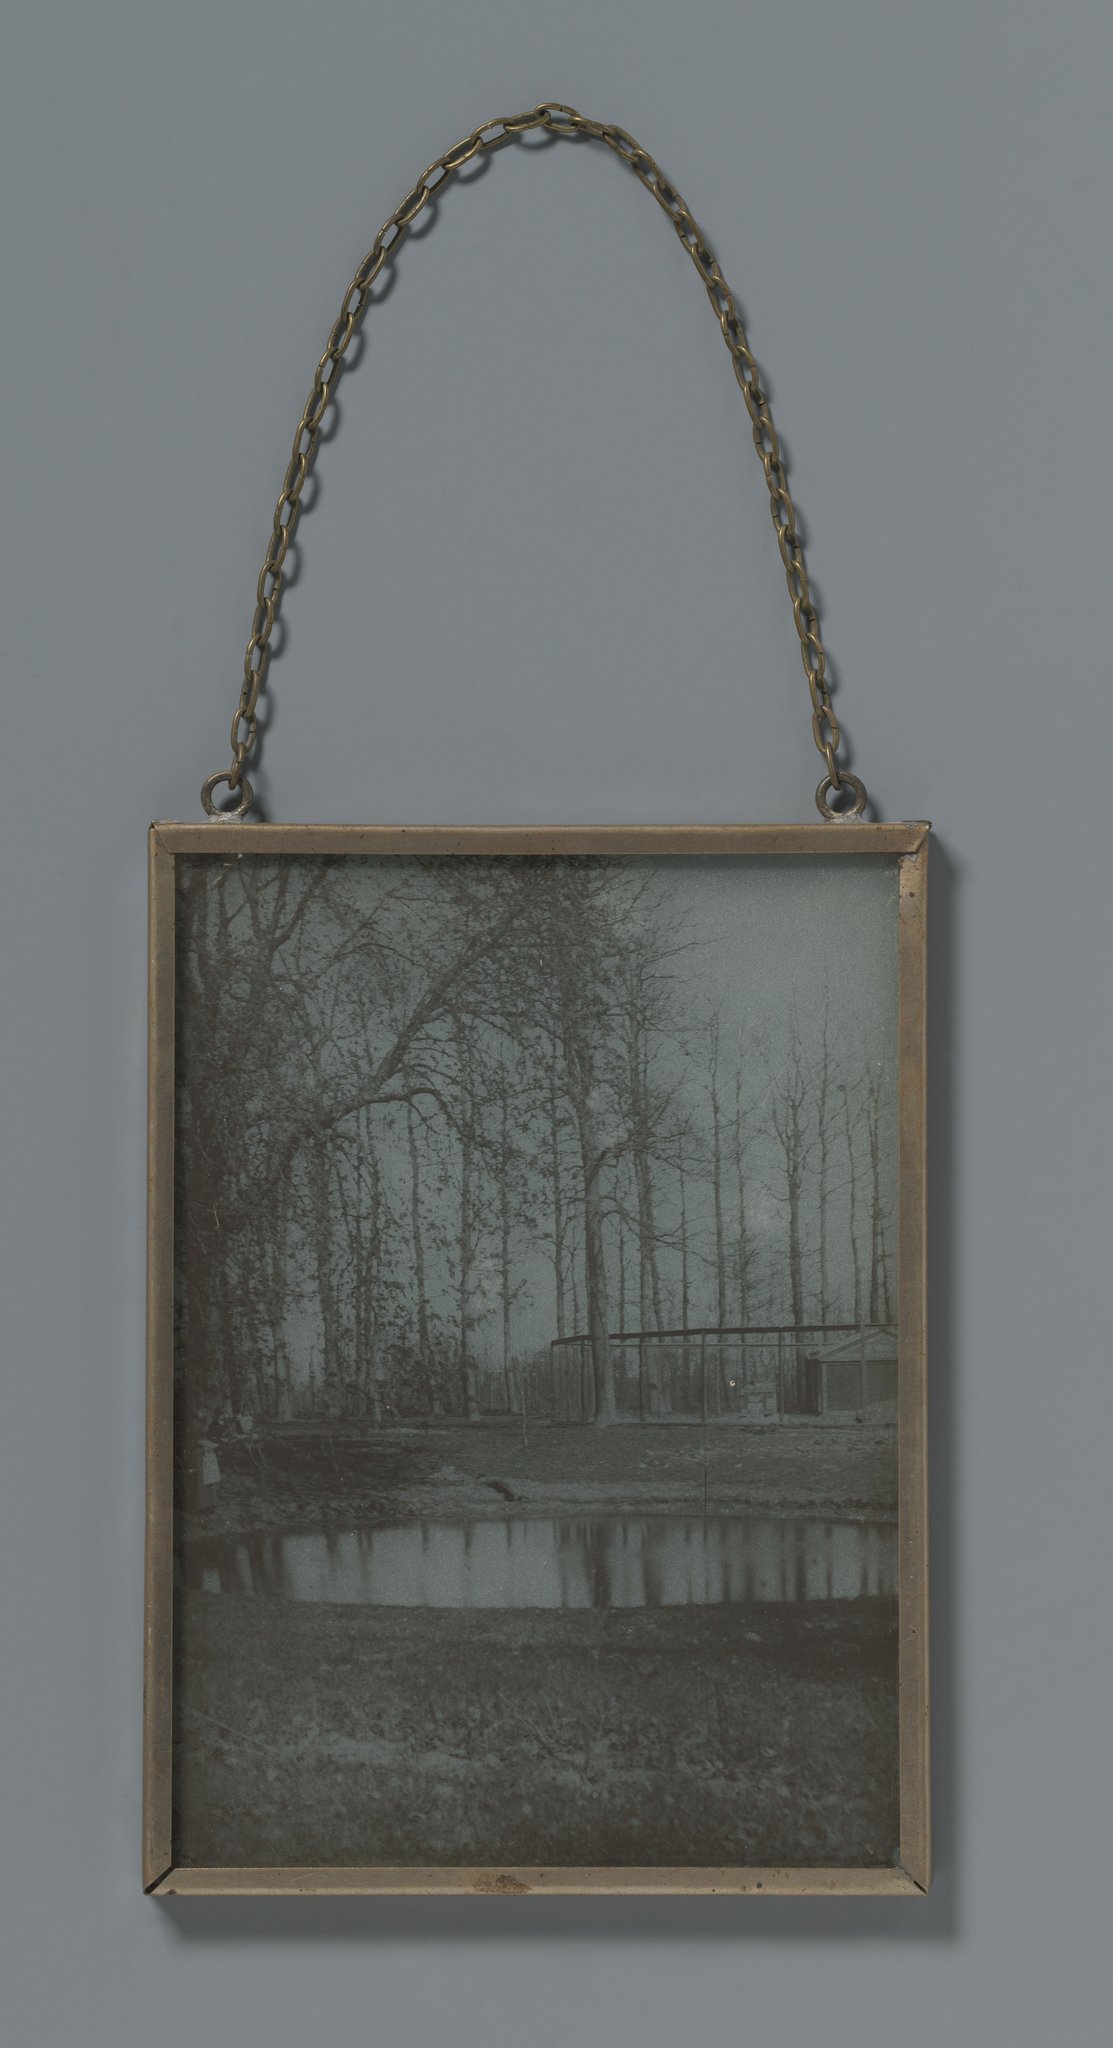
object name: photograph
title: Vijver in een park, drie onbekende mensen aan de oever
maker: Anonymous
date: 1880-1910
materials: glass, metal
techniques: slide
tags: garden pond